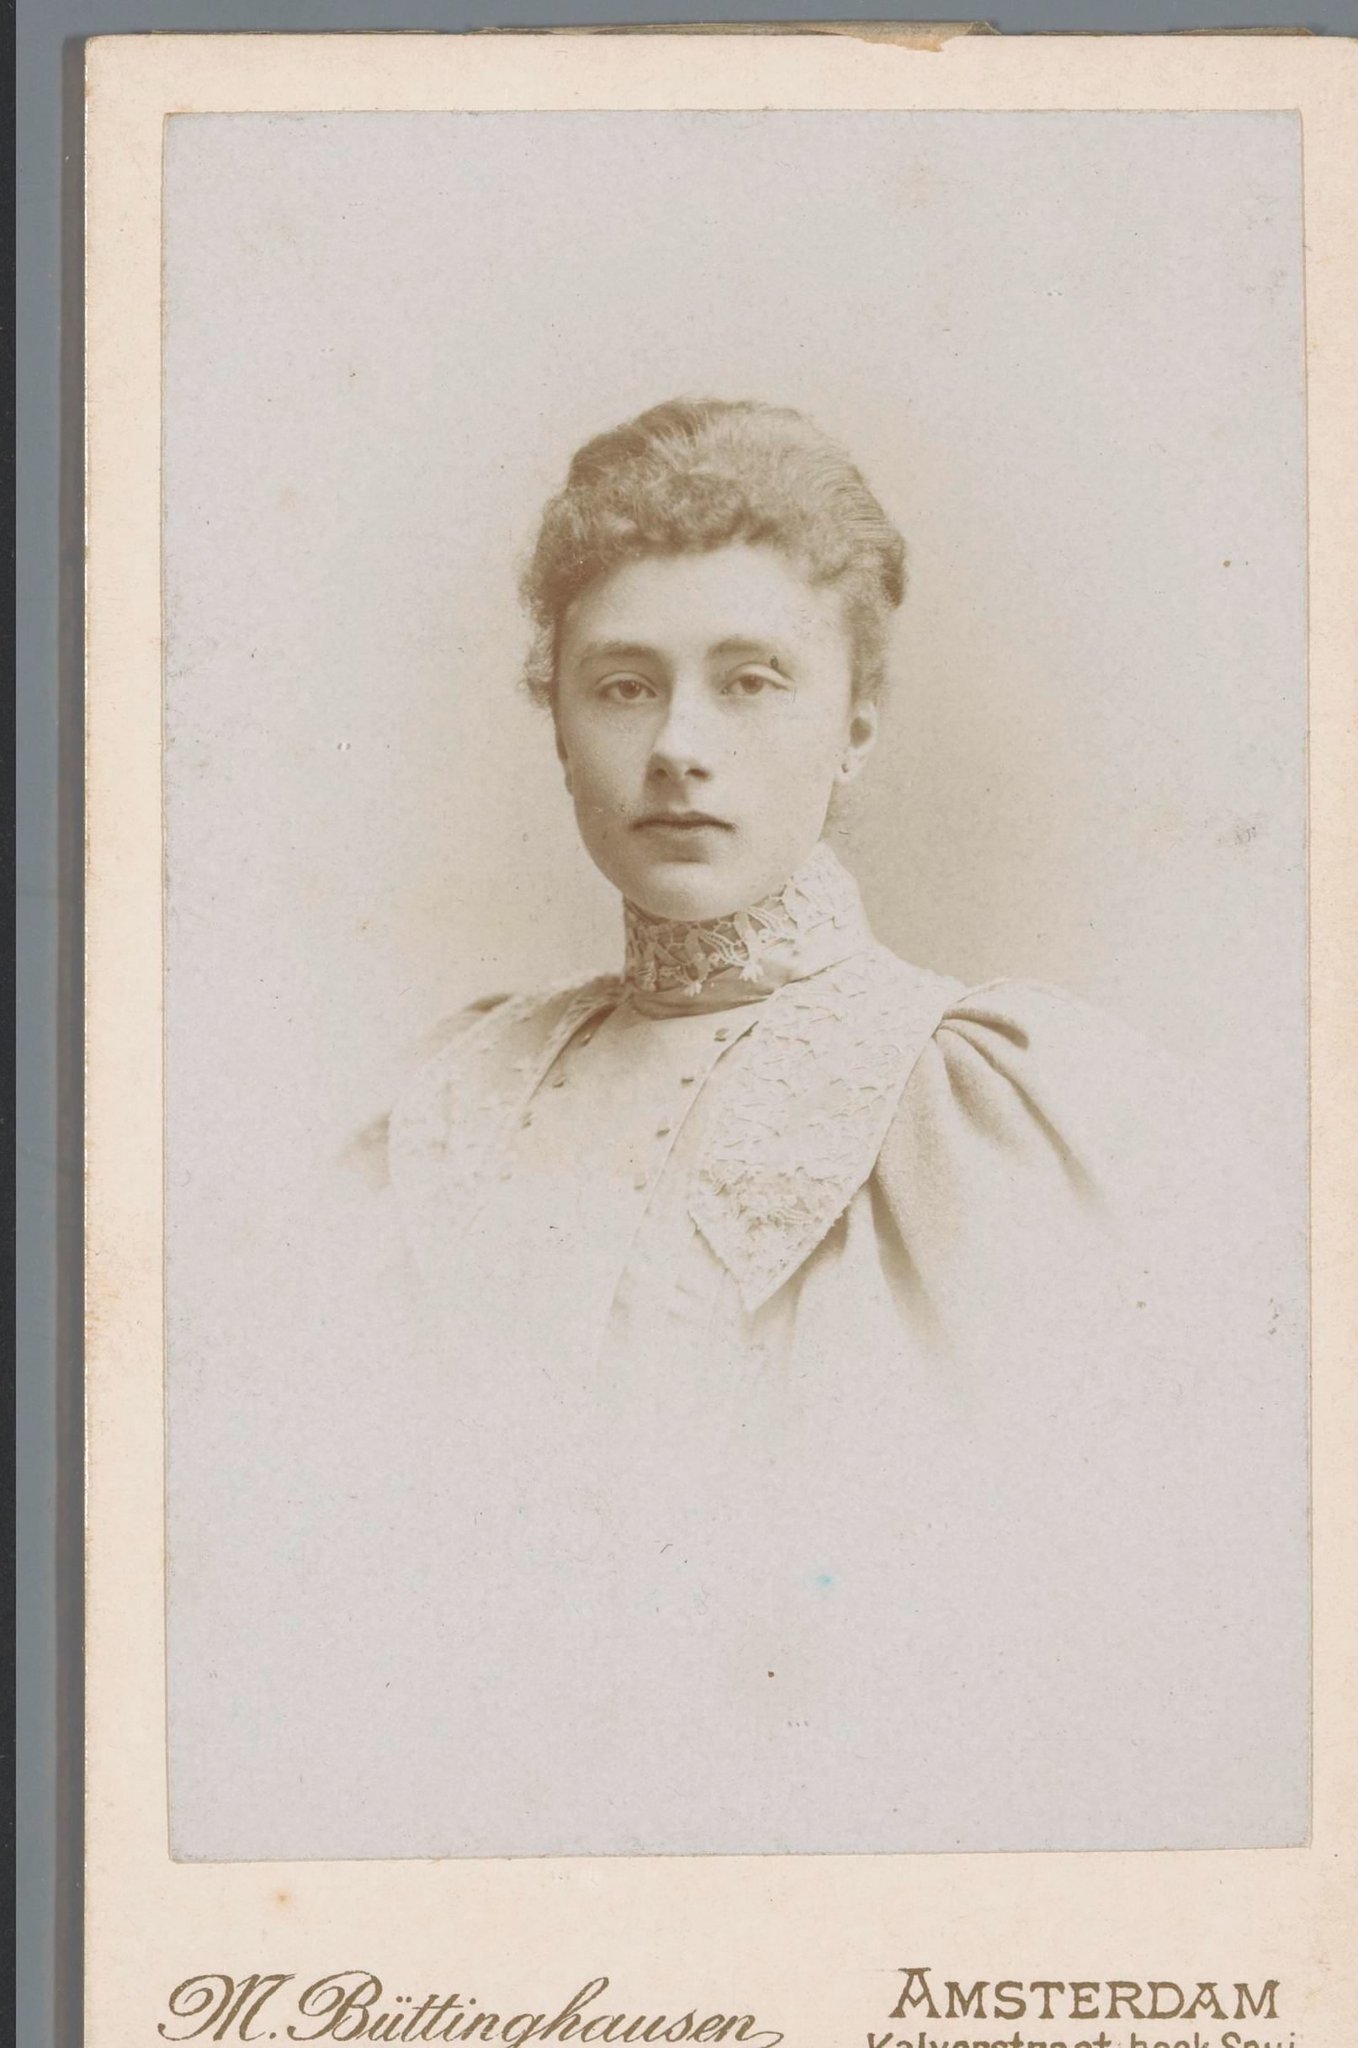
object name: carte de visite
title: Portret van een onbekende vrouw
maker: max büttinghausen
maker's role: fotograaf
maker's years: 1847-1906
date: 1886-1906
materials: paper, cardboard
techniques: collodion silver print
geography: amsterdam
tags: adult woman, anonymous historical person portrayed, amsterdam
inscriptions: inscription: ‘M. Büttinghausen/ Amsterdam/ Kalverstraat hoek Spui.’, inscription: ‘M. Büttinghausen/ Amsterdam Kalverstraat hoek Spui/ eenig Atelier/ Specialiteit/ in/ Vergrootingen/ Onveranderlijke/ Kooldruk/ De plaat blijft ter/ nabestelling bewaard./ Alex Lindner Berlin.’